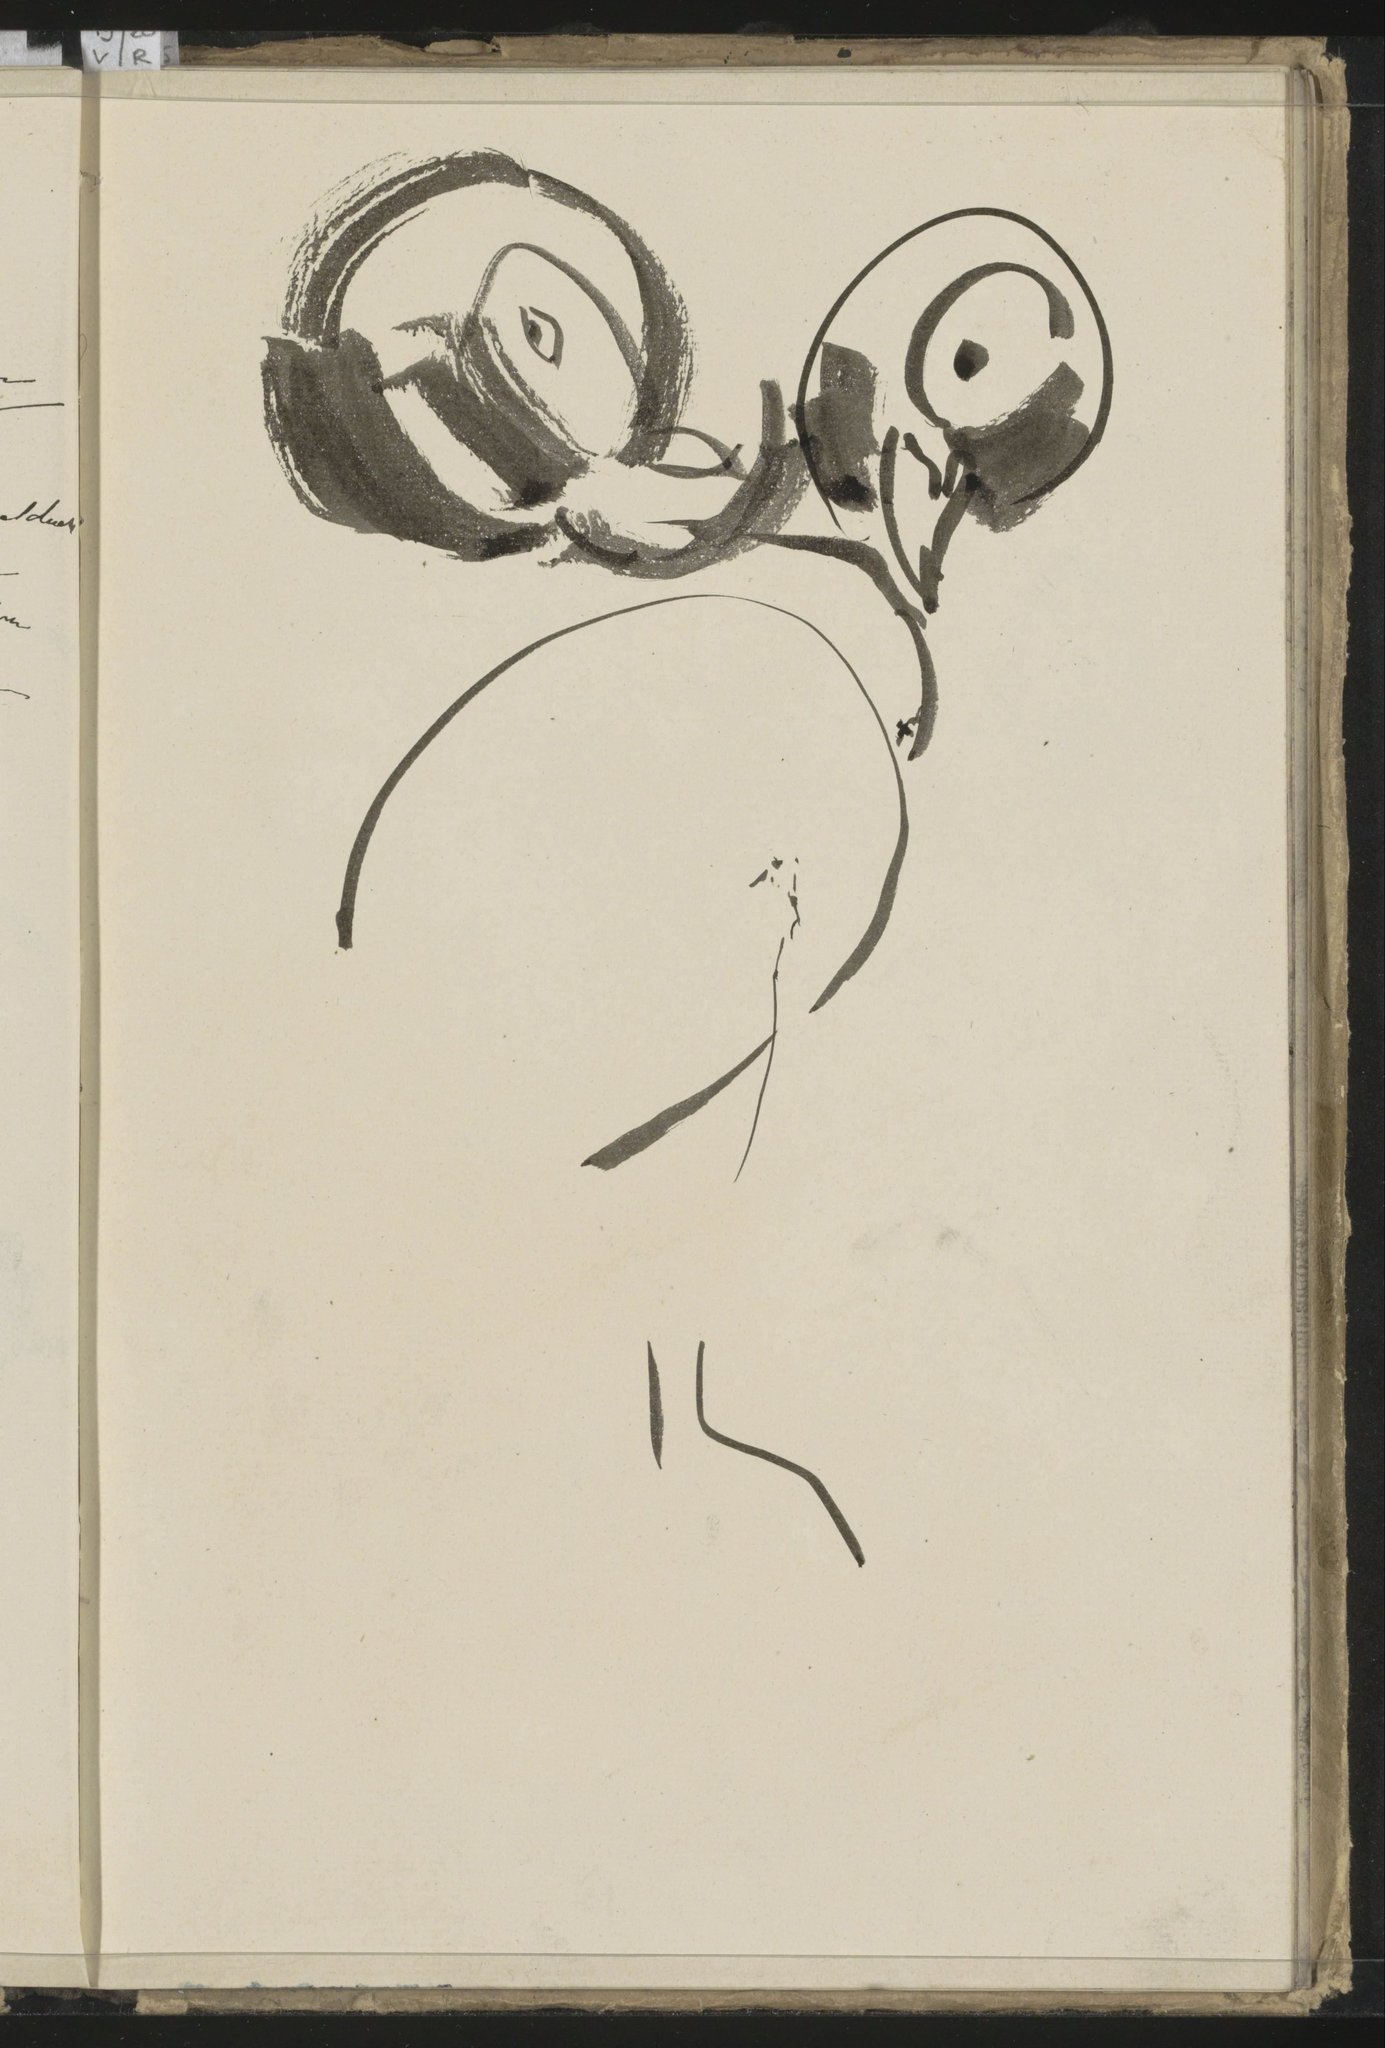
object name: sketchbook leaf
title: Koppen van papegaaien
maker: carel adolph lion cachet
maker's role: draughtsman, print maker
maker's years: 1864-1945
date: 1890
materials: ink, paper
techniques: brush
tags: ornamental birds: parrot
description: Blad 19 recto uit een schetsboek met 38 bladen.